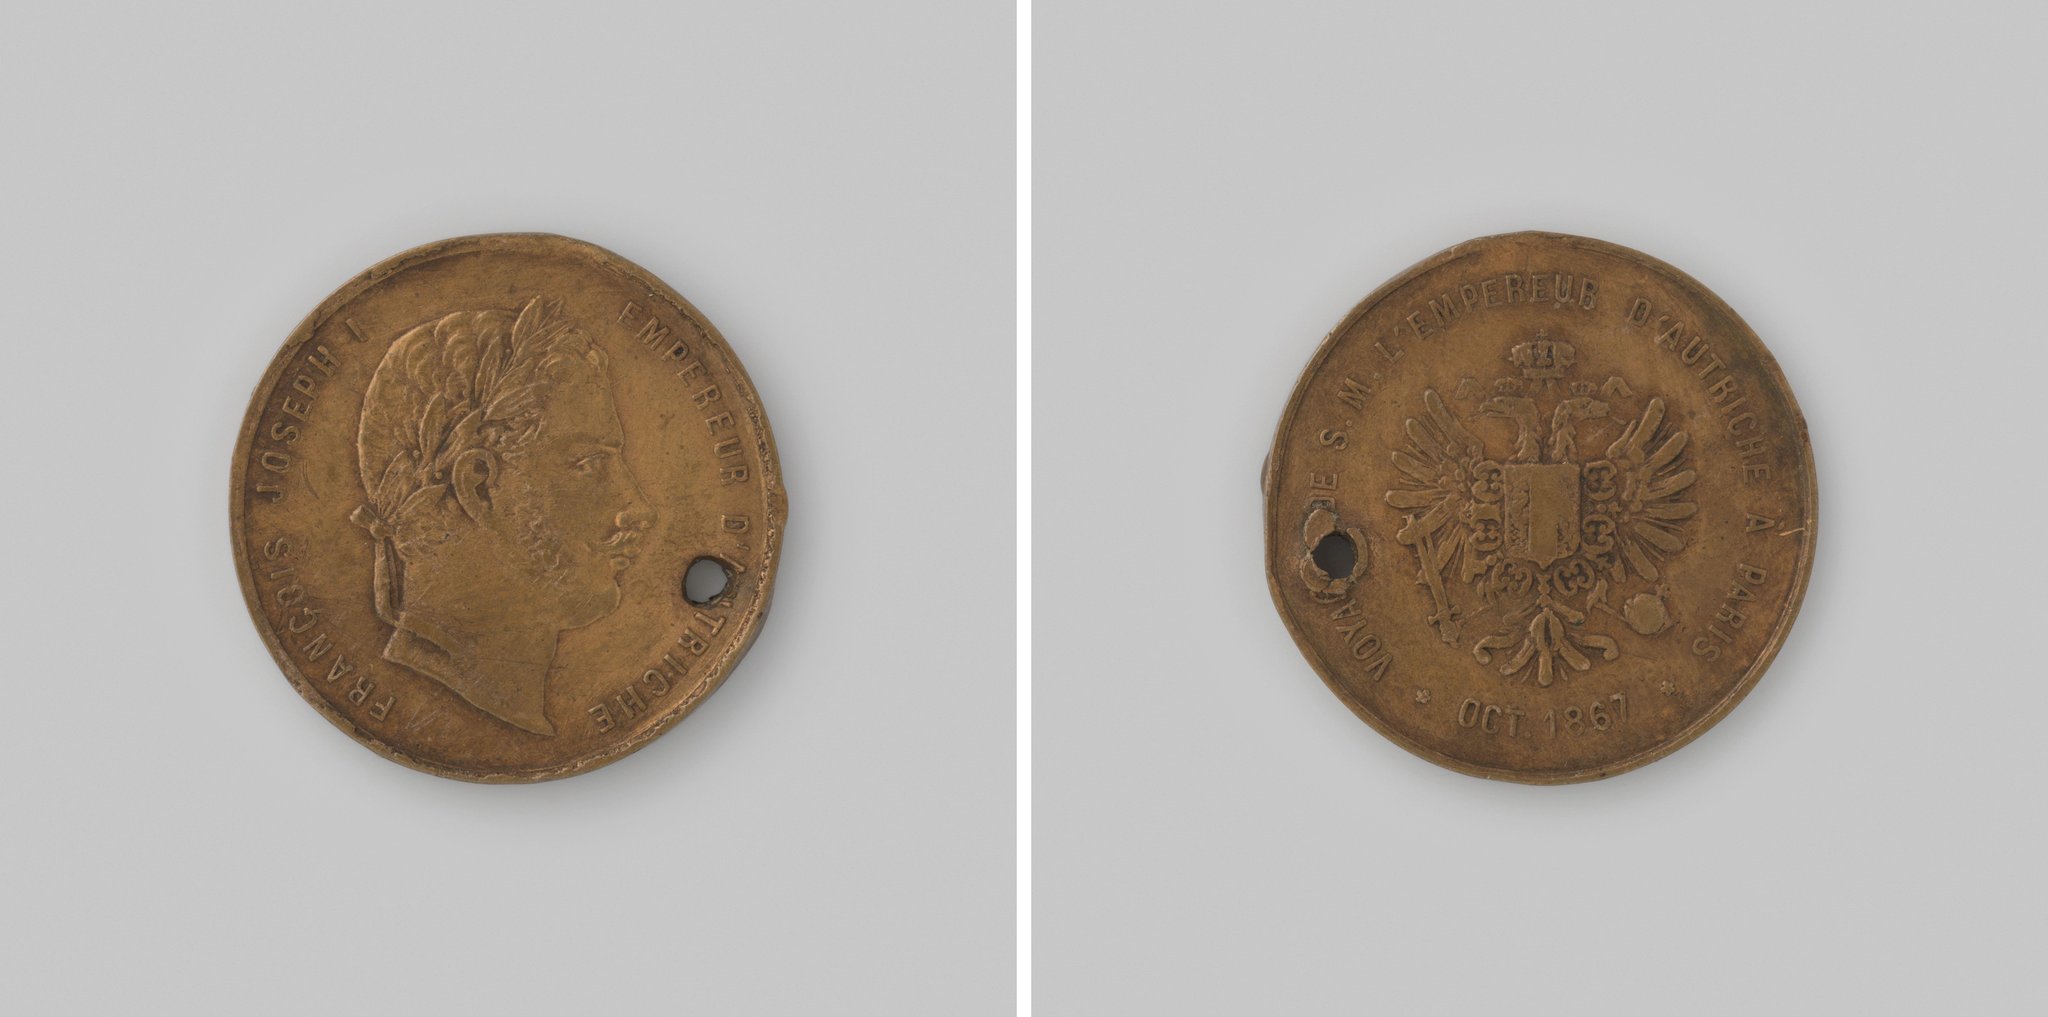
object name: history medal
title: Bezoek van Keizer Frans Josef van Oostenrijk aan Parijs 1867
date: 1867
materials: brass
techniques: striking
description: Messing penning met doorboring, op de voorzijde het portret van Frans Josef naar rechts met omschrift, op de keerzijde de Oostenrijks adelaar met omschrift.